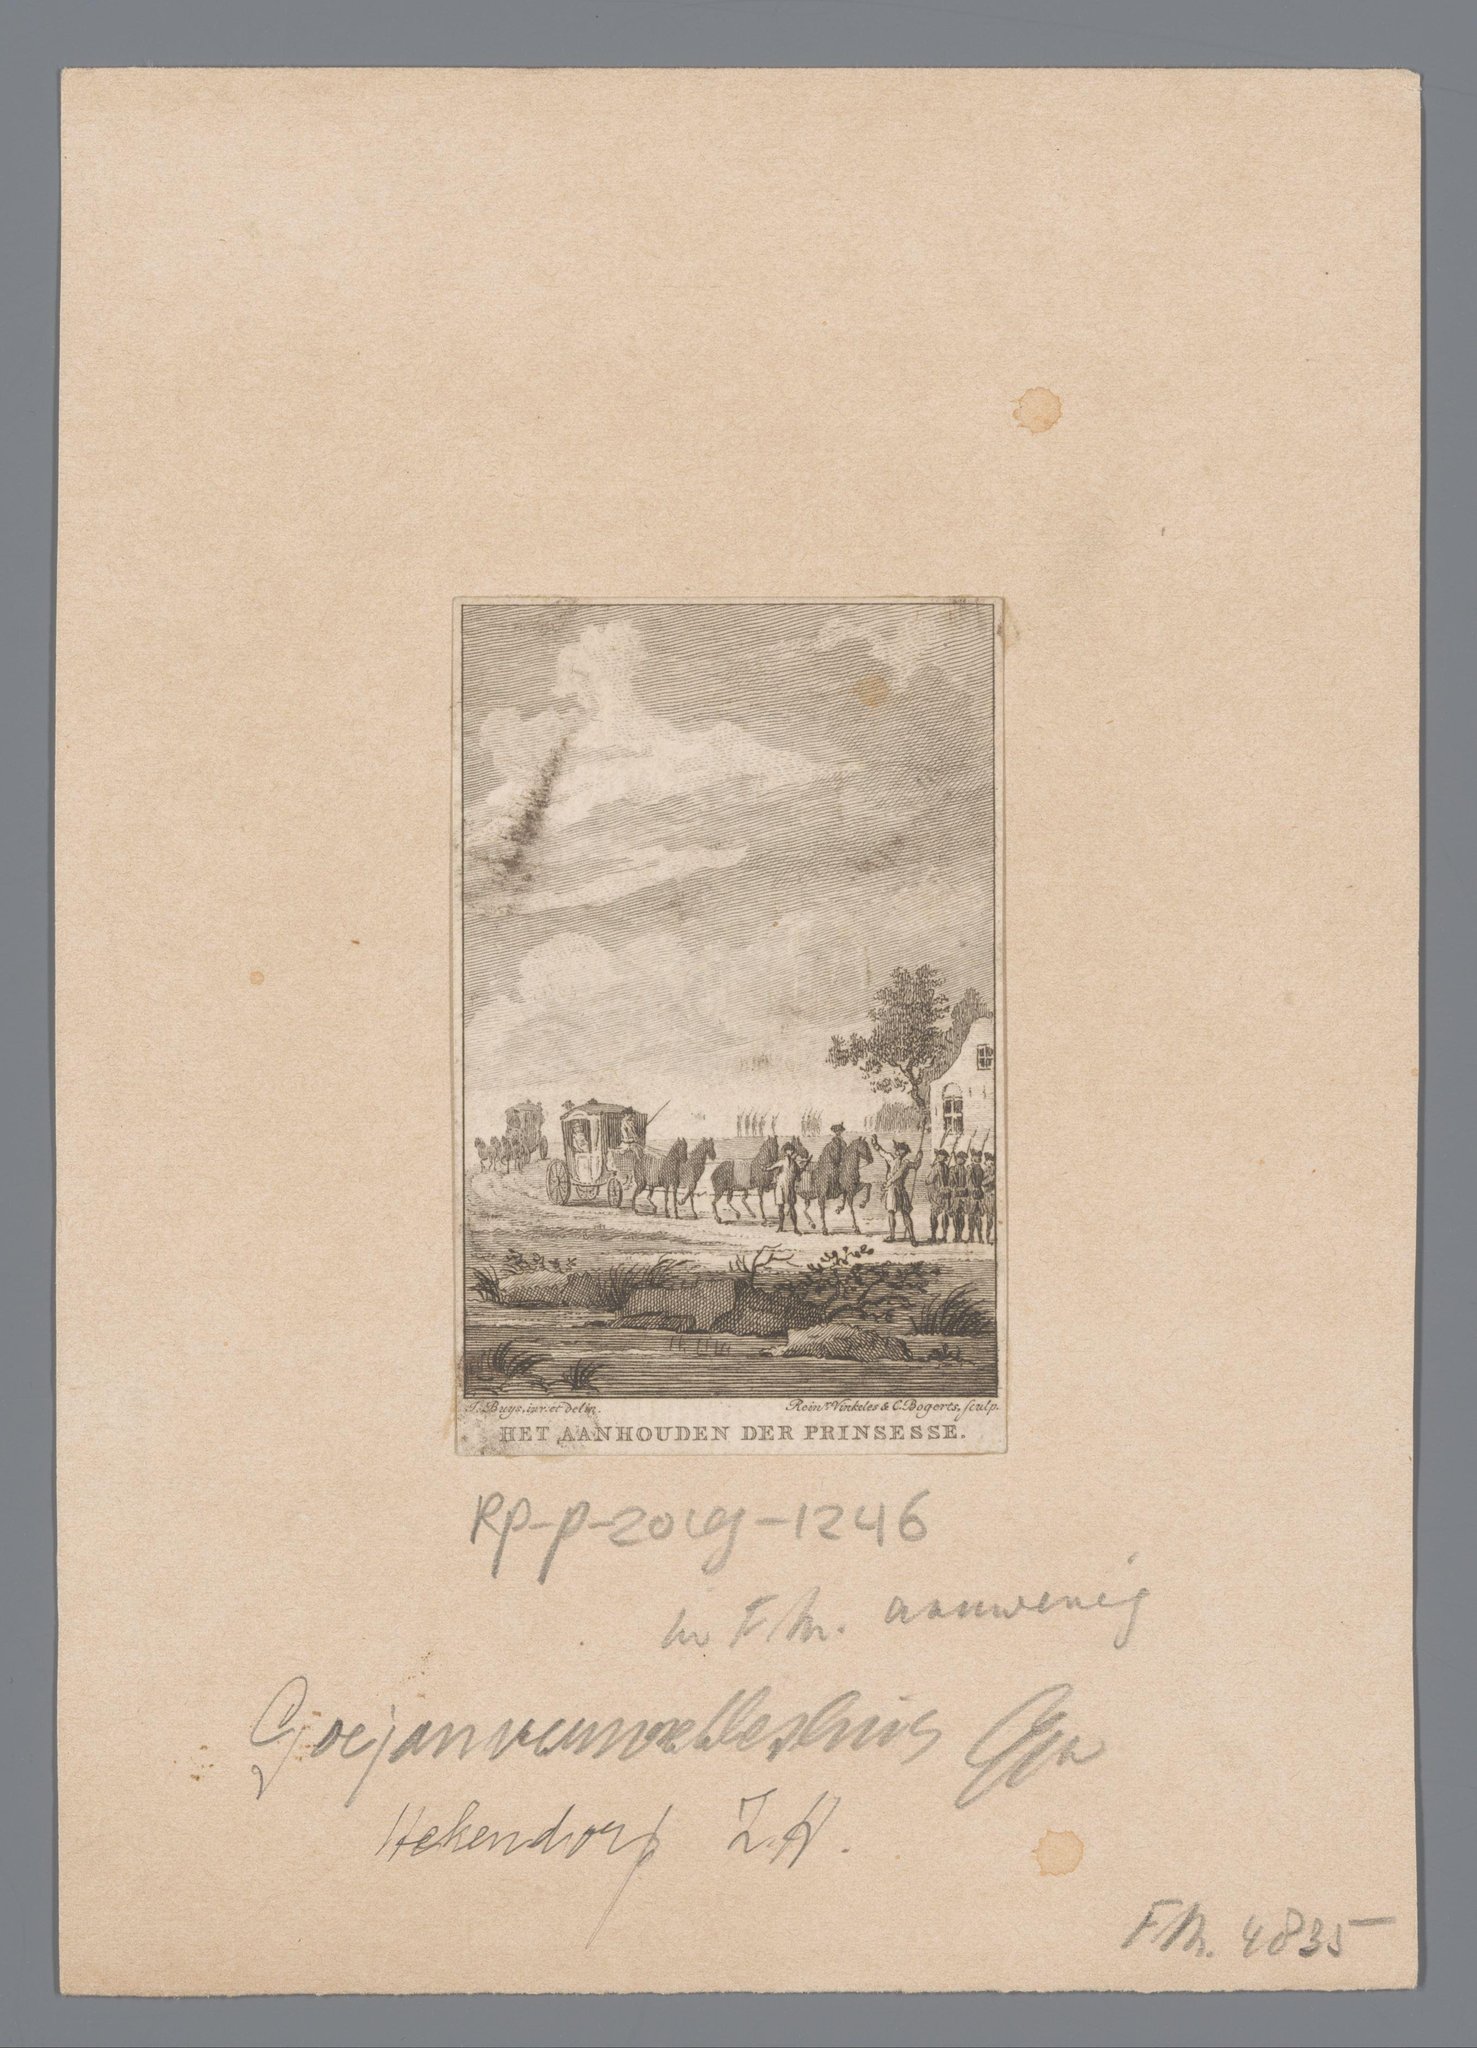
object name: book illustration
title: Het aanhouden der prinsesse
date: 1791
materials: paper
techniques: etching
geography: amsterdam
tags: berlin, draughtsman, wilhelmina of prussia (princess of orange), patriot (revolutionary)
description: Prent uit: Fokke, J. Geschiedenissen der Vereenigde Nederlanden voor de vaderlandsche jeugd. Amsterdam: Johannes Allart, 1791, dl. 17, tussen p. 252 en 253.